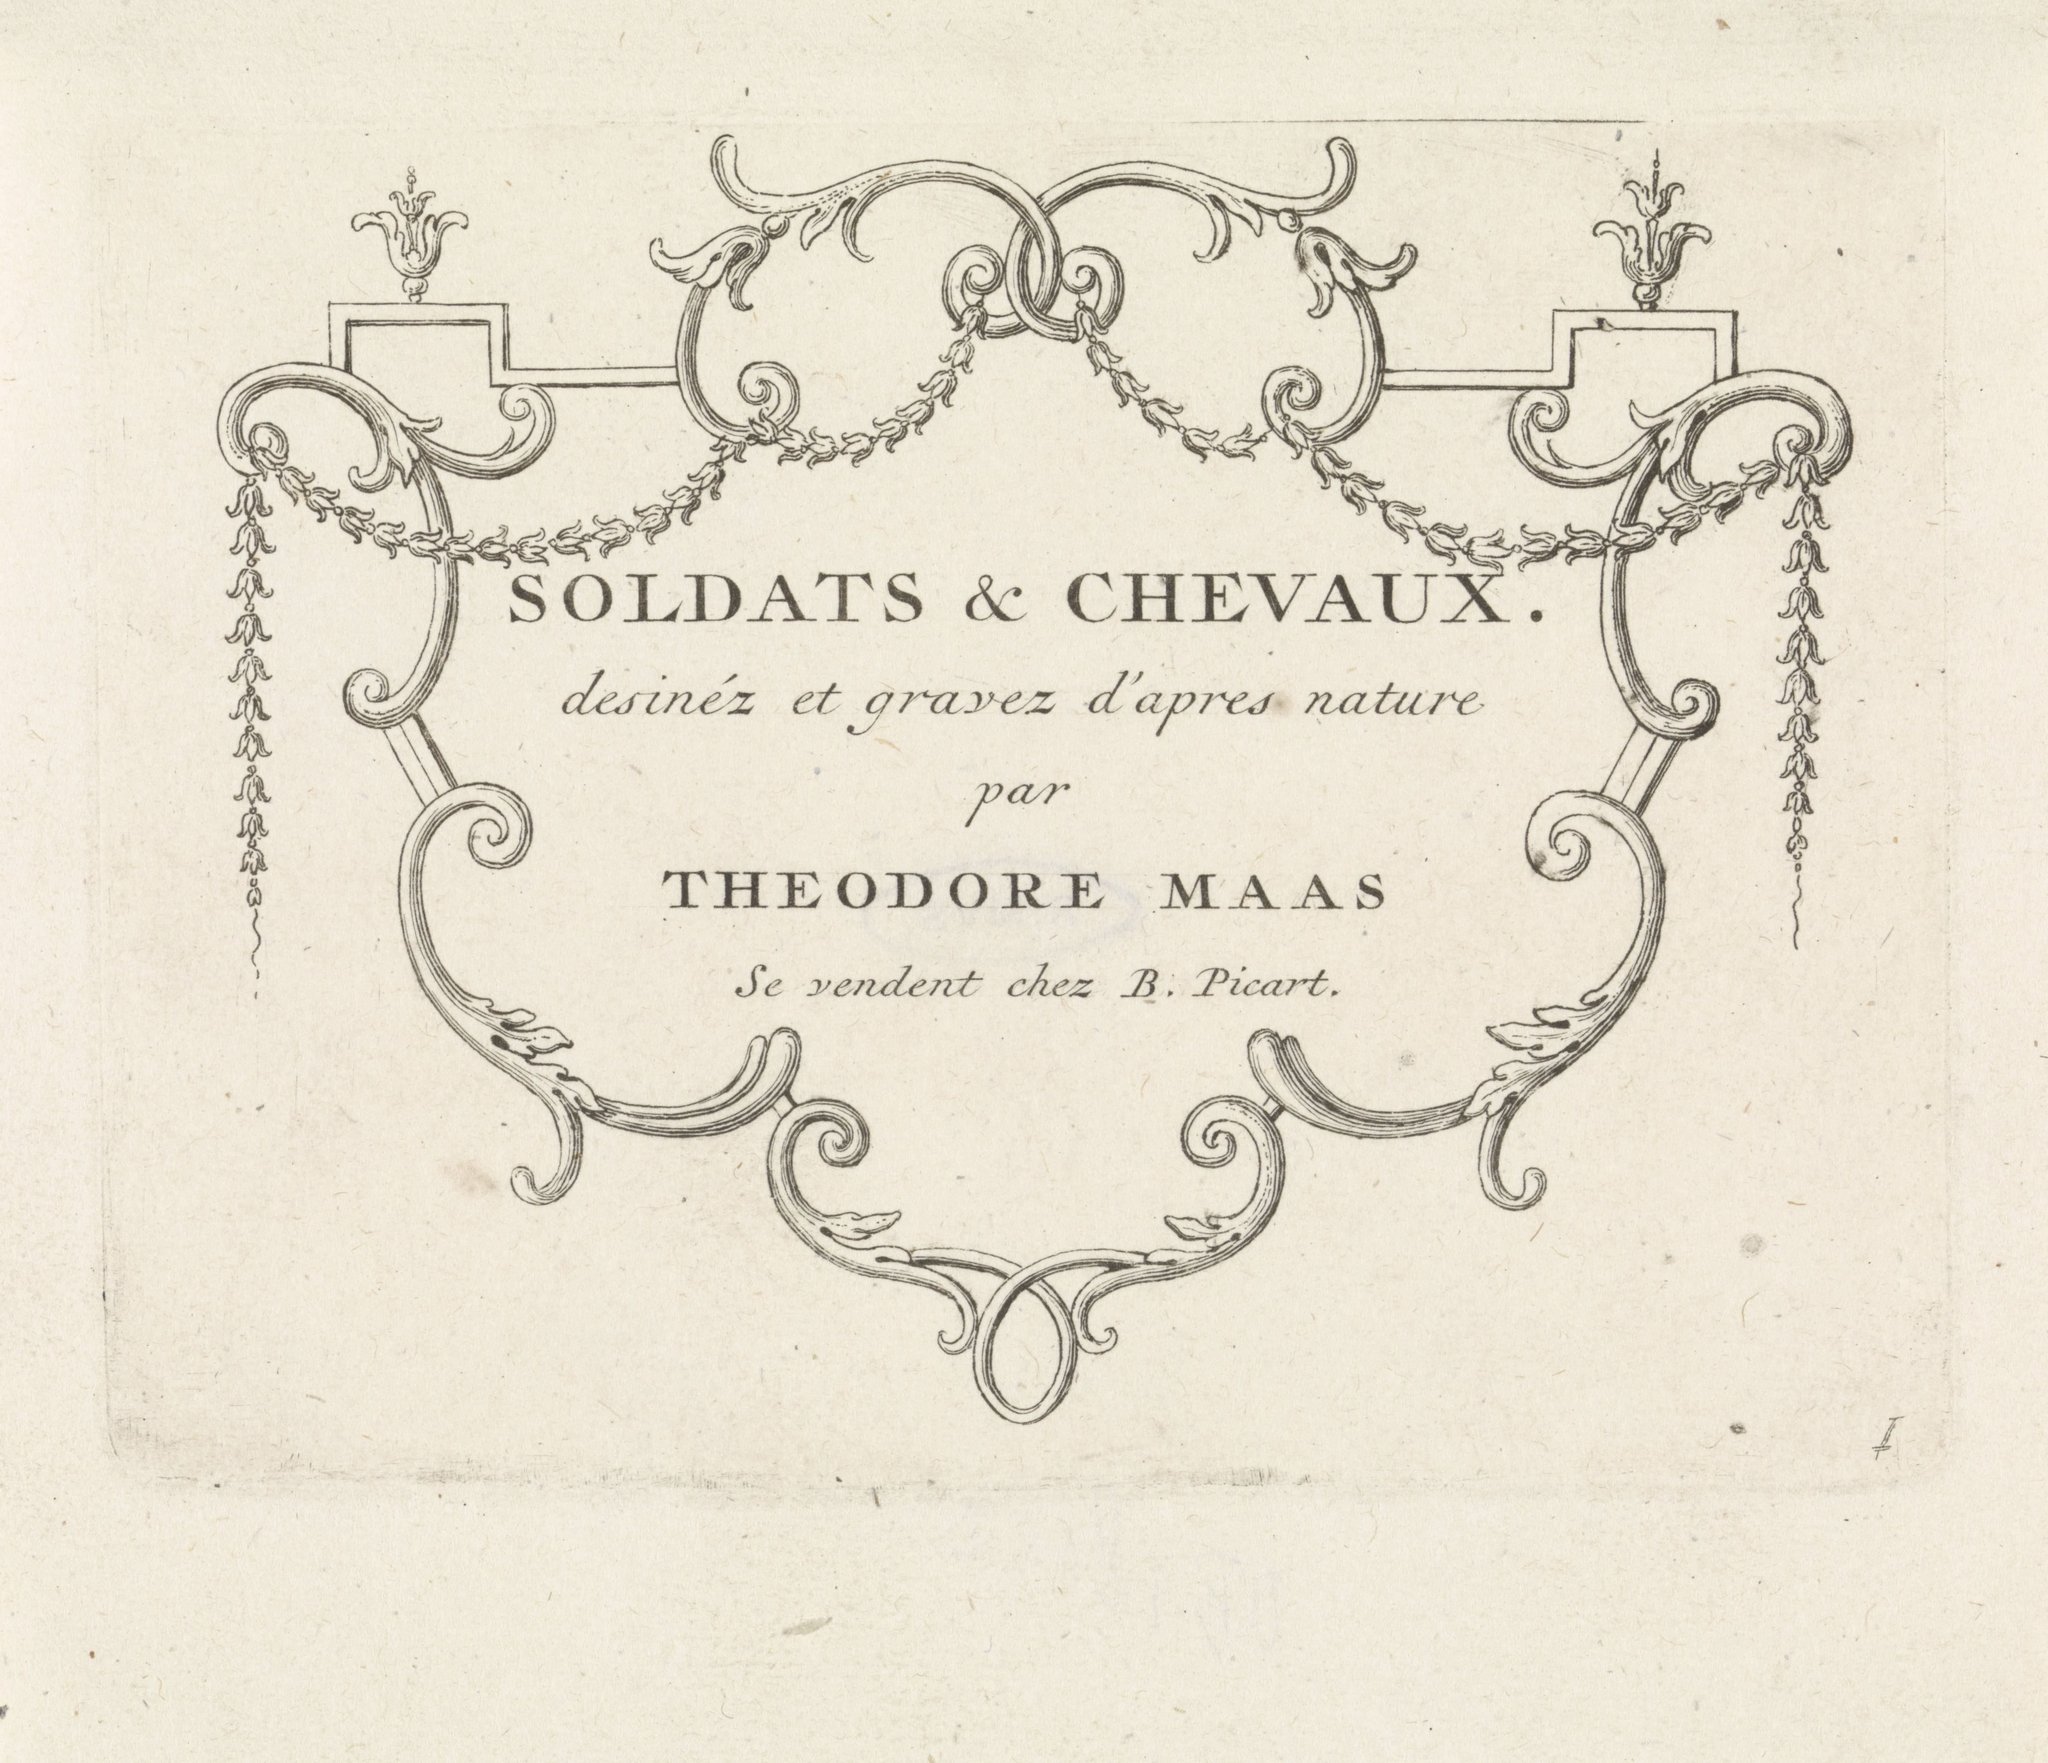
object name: print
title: Soldats & Chevaux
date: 1710-1717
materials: paper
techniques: engraving, etching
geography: amsterdam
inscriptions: collector's mark: Lugt 2228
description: Titelprent met vijf regels in het Frans, waaromheen versiering. Eerste prent uit een serie van twaalf prenten met voorstellingen van soldaten en paarden.